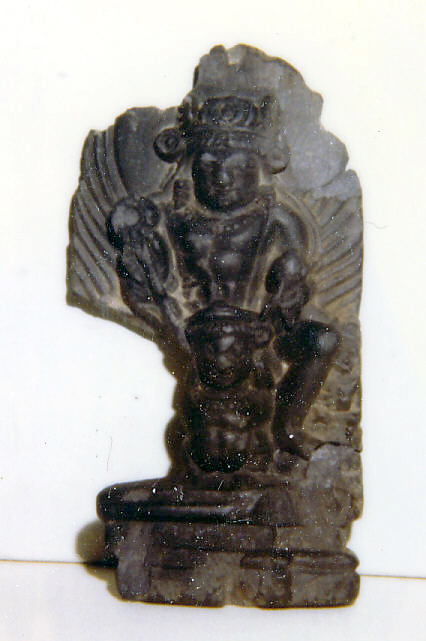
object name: relief fragment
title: Seated Vishnu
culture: indian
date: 601-900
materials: stone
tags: kashmir